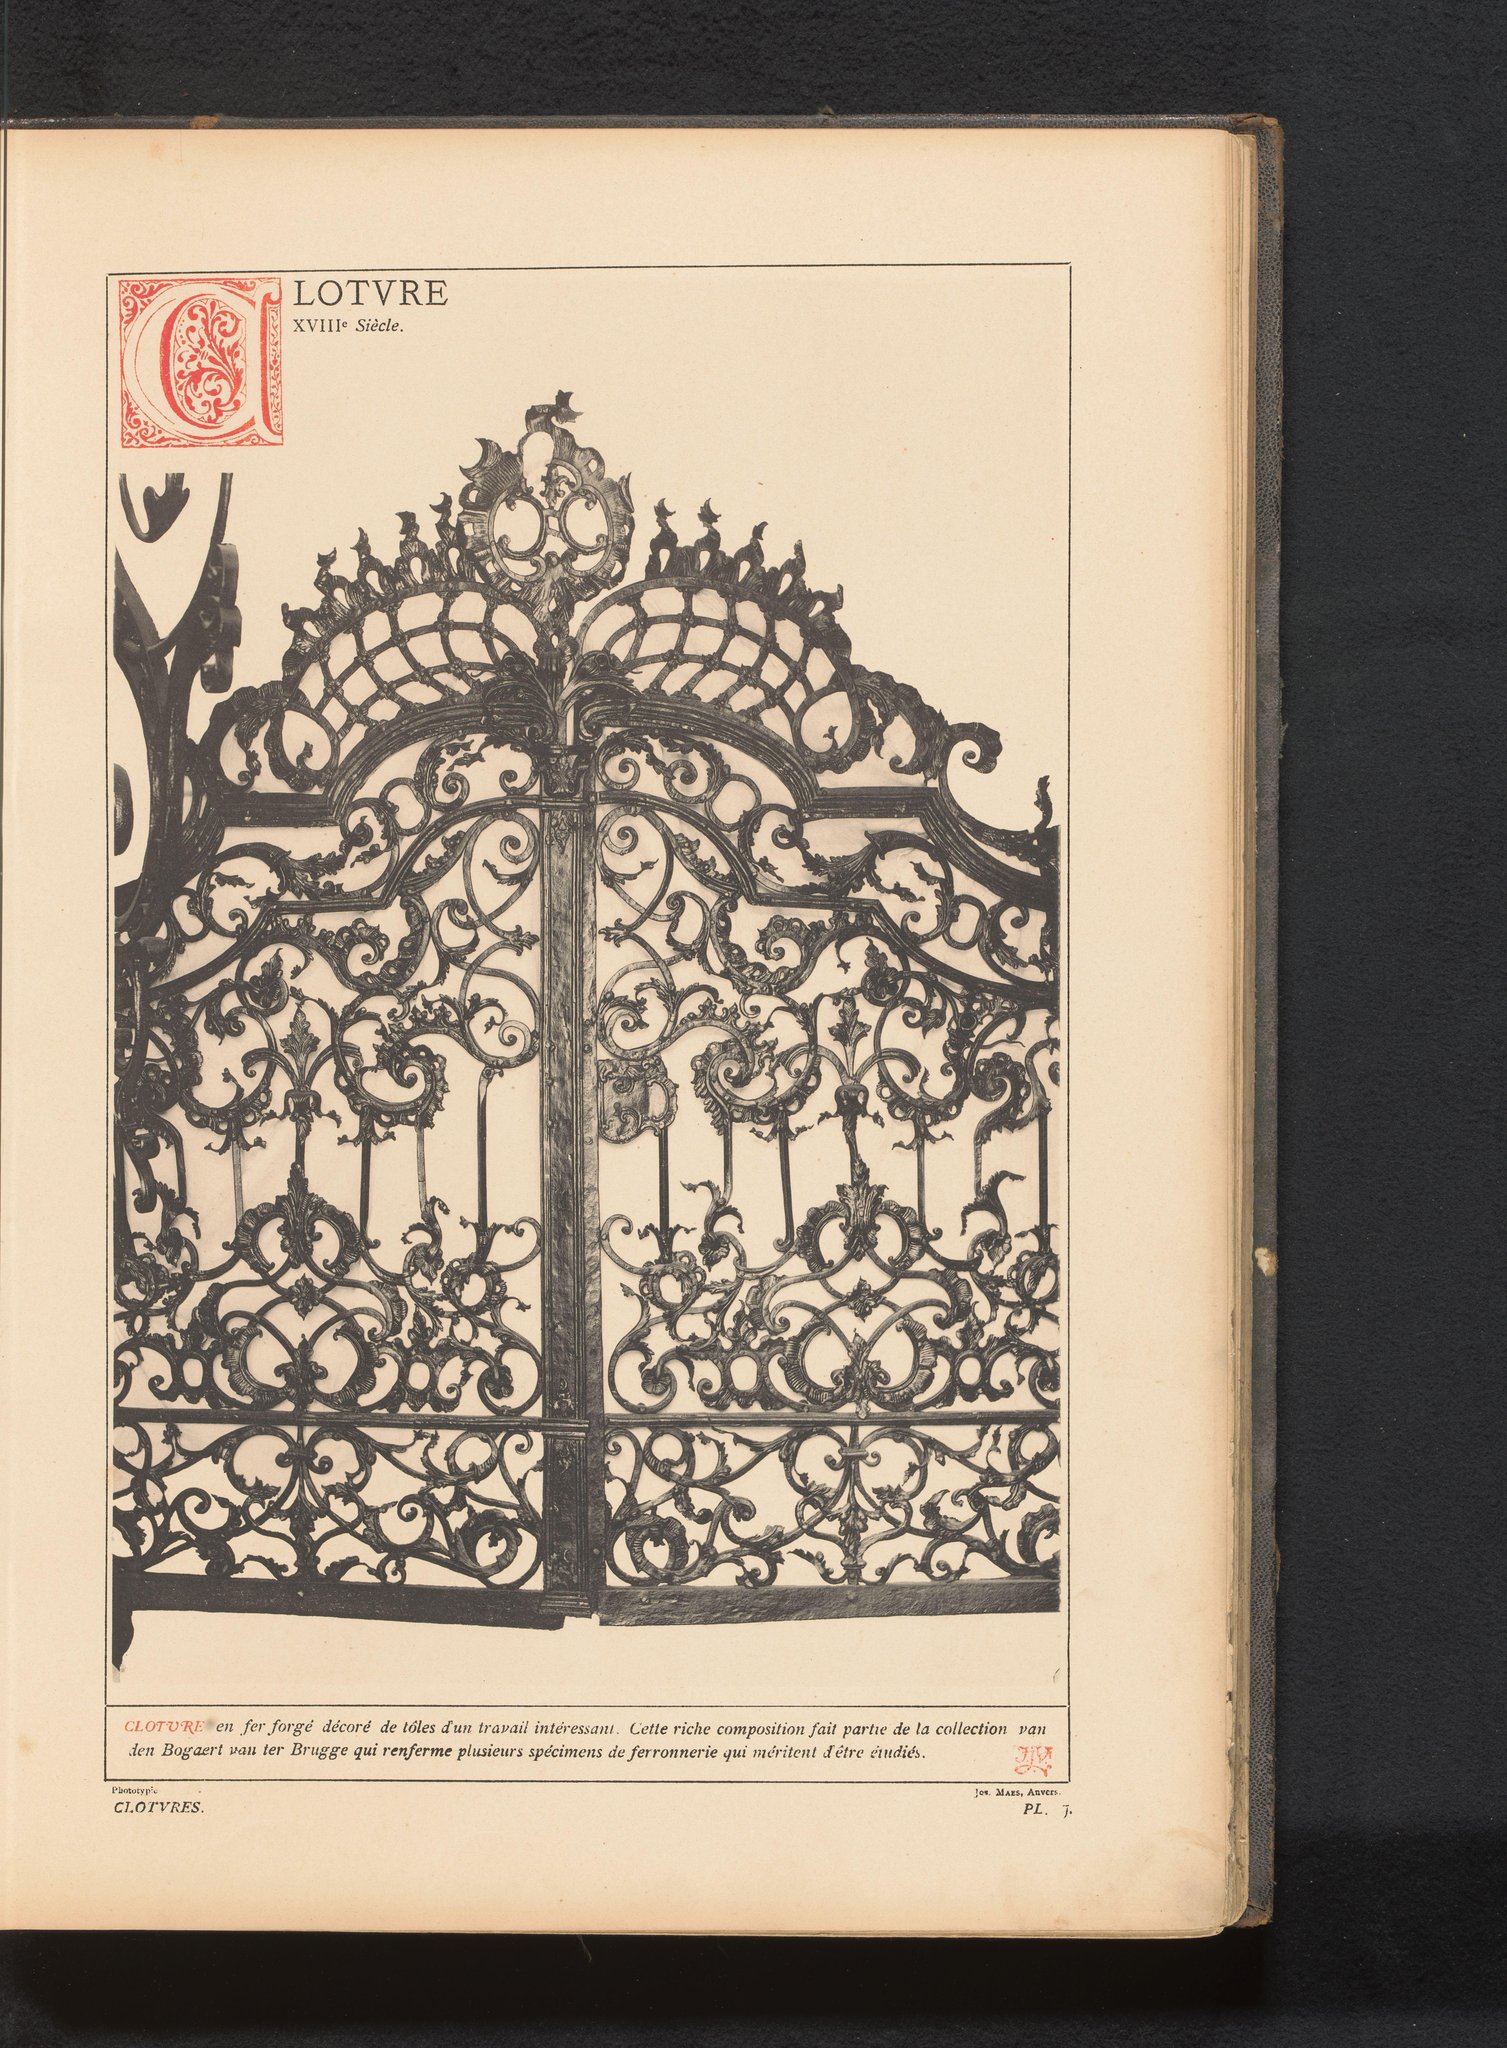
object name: photomechanical print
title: Cloture, XVIIIe Siècle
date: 1881-1889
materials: paper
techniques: photograph, photolithography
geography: antwerp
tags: fence, wall, paling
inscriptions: inscription: ‘COTURES. PL. 7.’, inscription: ‘CLOTURE en fer forgé (...)’, monogram: ‘JJvY’